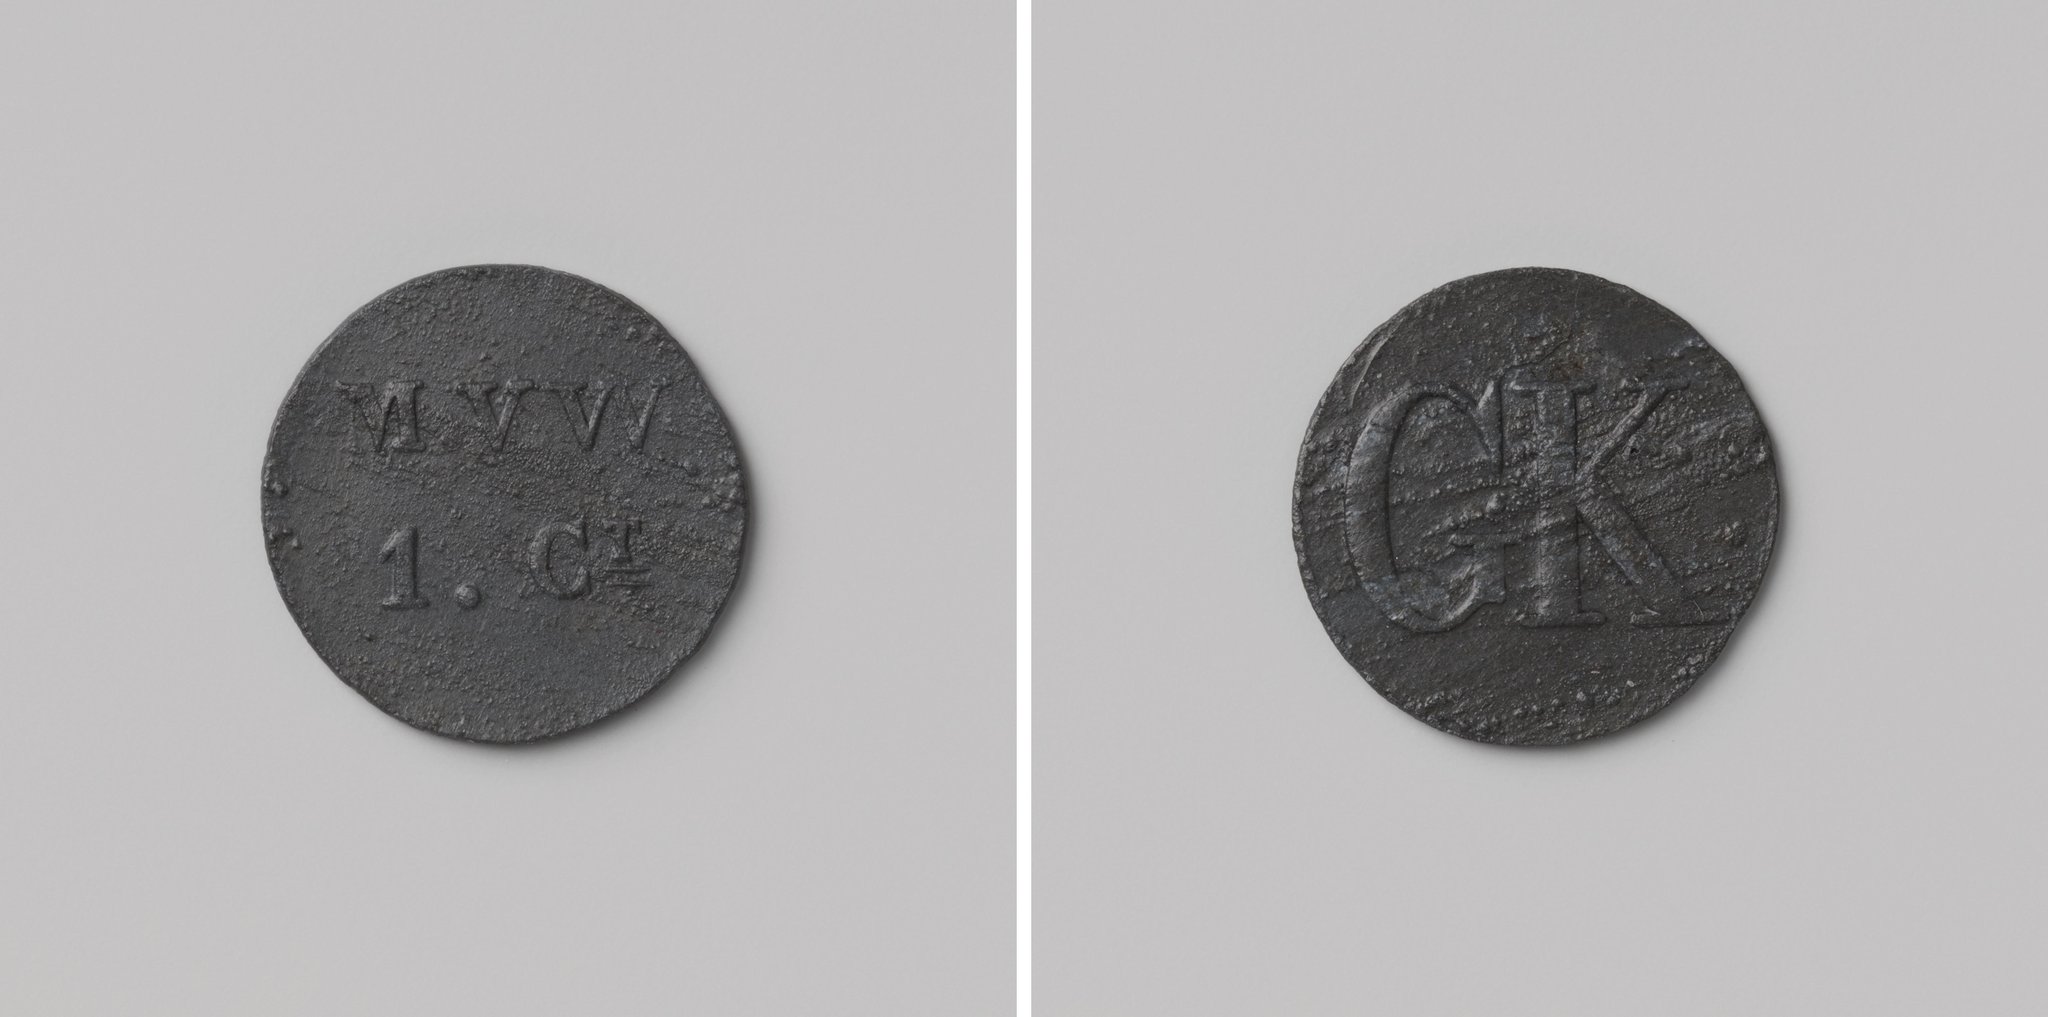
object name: cent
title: Huismunt geslagen op last van de Maatschappij van Weldadigheid ter waarde van 1 cent, ten behoeve van de Gewone Koloniën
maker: Anonymous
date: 1818-1859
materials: zinc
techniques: striking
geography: netherlands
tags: maatschappij van weldadigheid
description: Zinken munt. Voorzijde: opschrift boven waardeaanduiding. Keerzijde: opschrift G en K